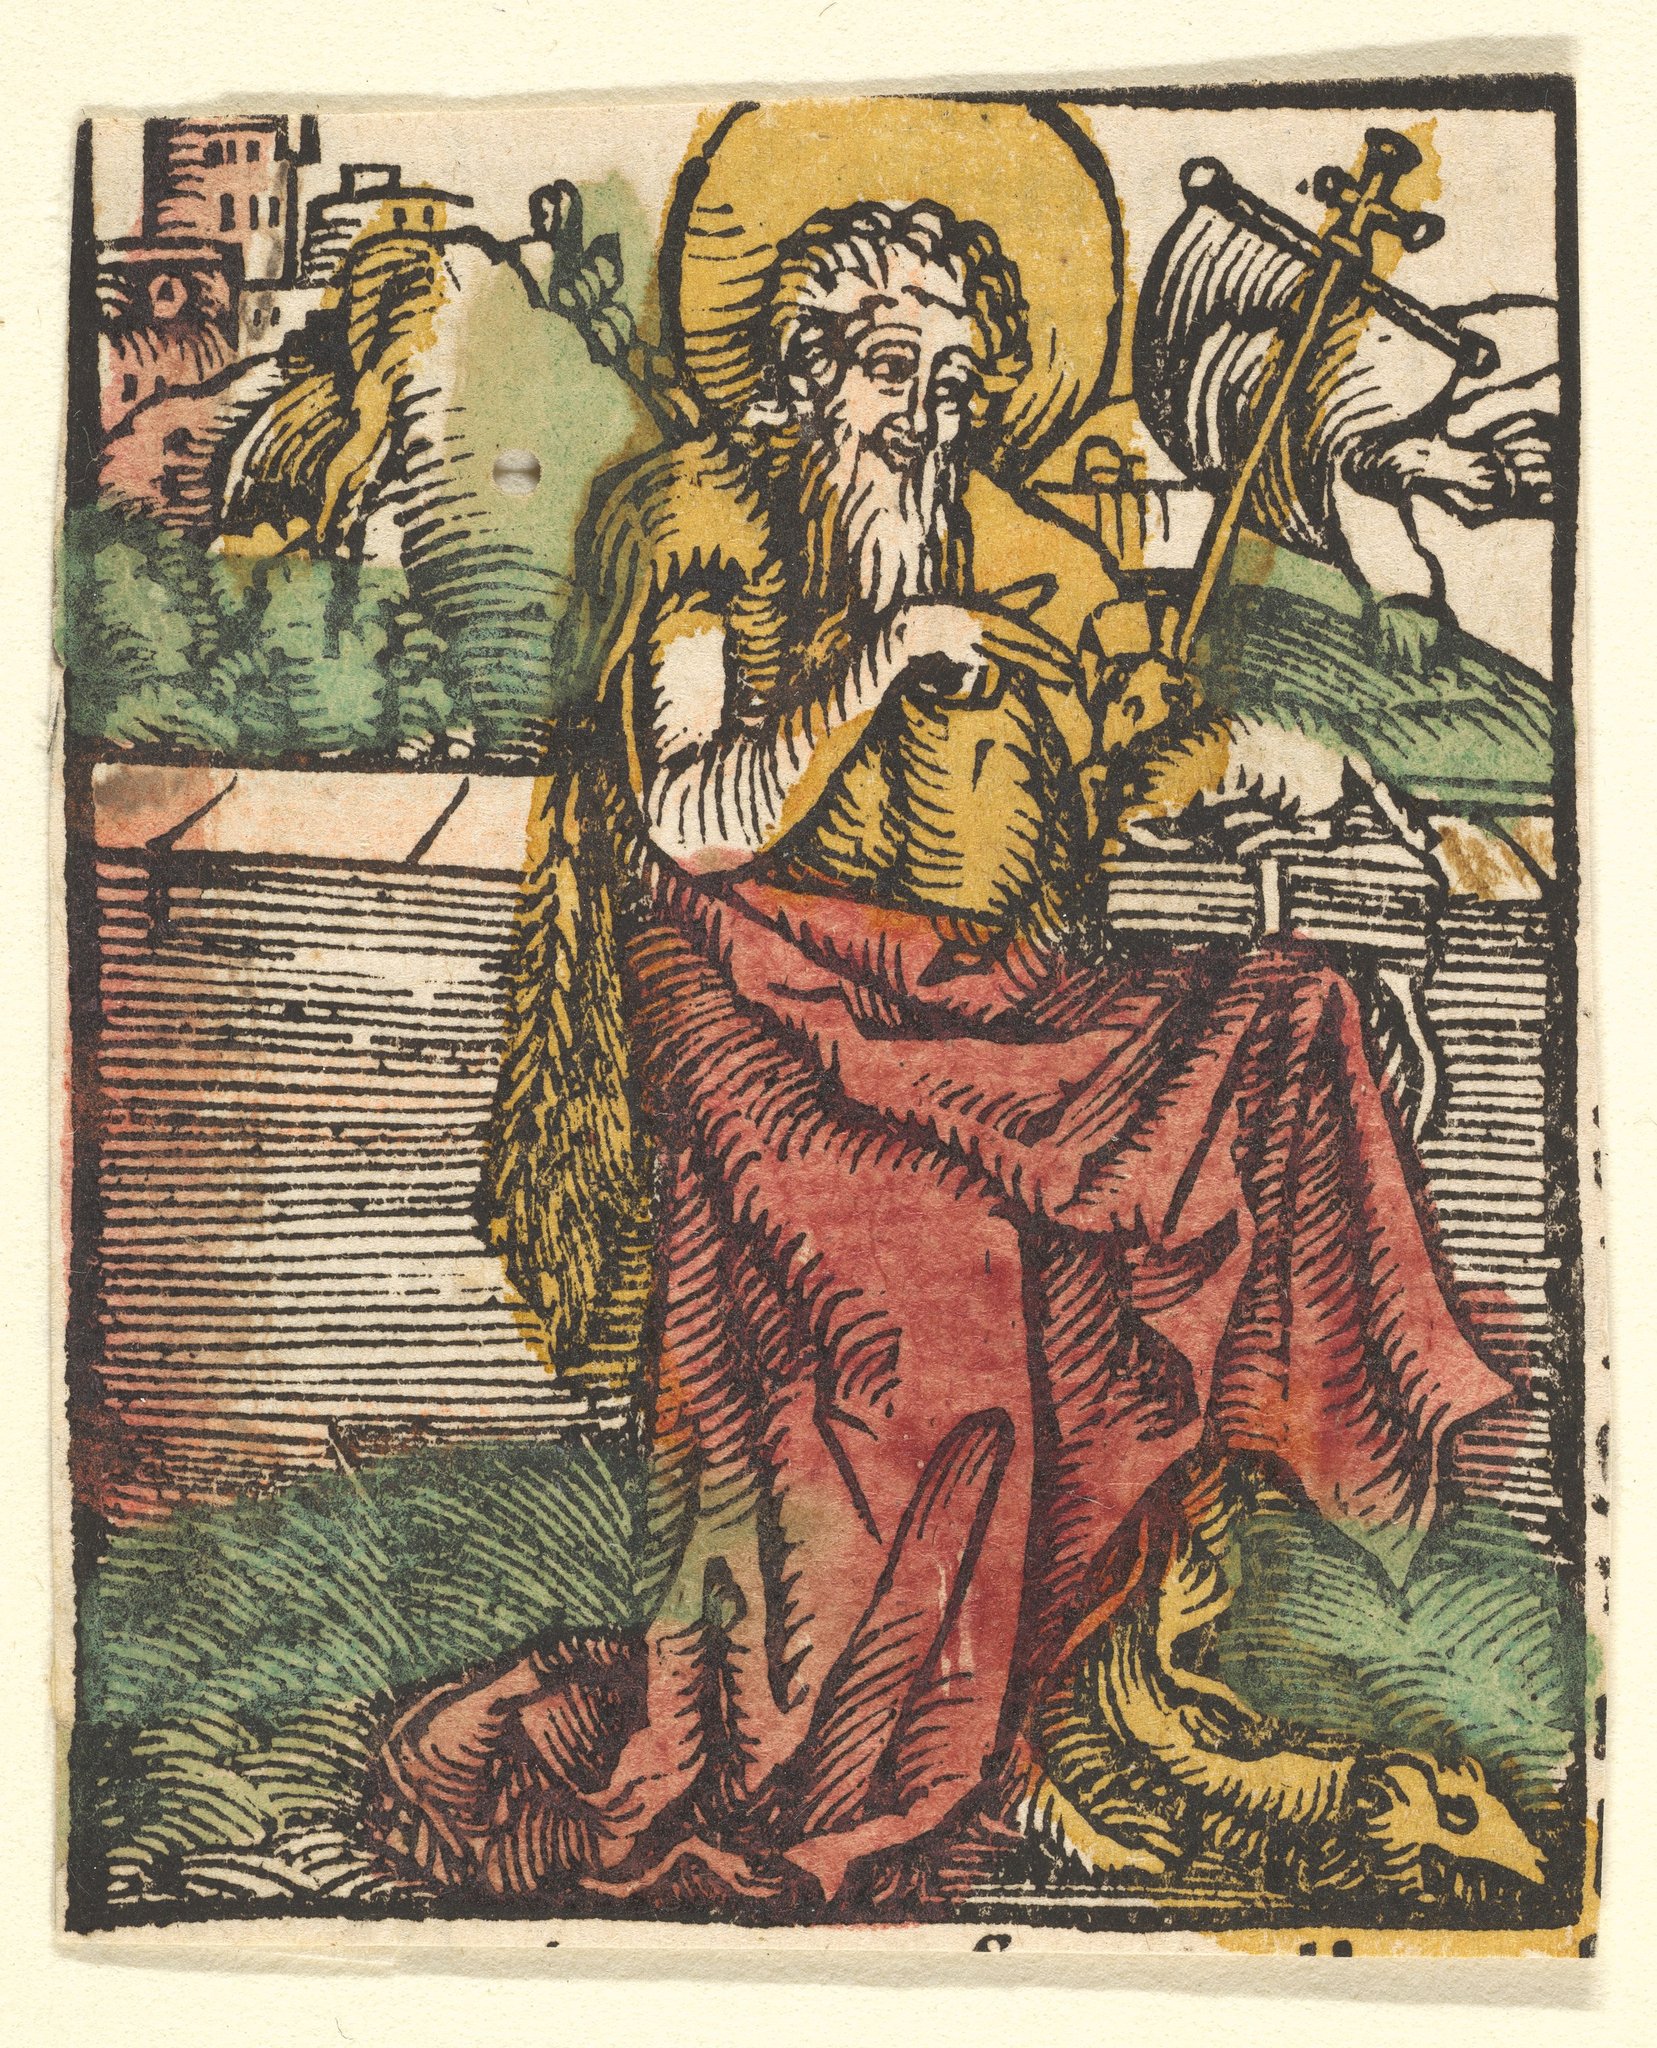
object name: print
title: St. John the Baptist (copy)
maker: hans baldung (called hans baldung grien)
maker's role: artist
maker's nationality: german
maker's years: 1484-1545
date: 1511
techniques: hand coloring, woodcut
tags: saint john the baptist,cross